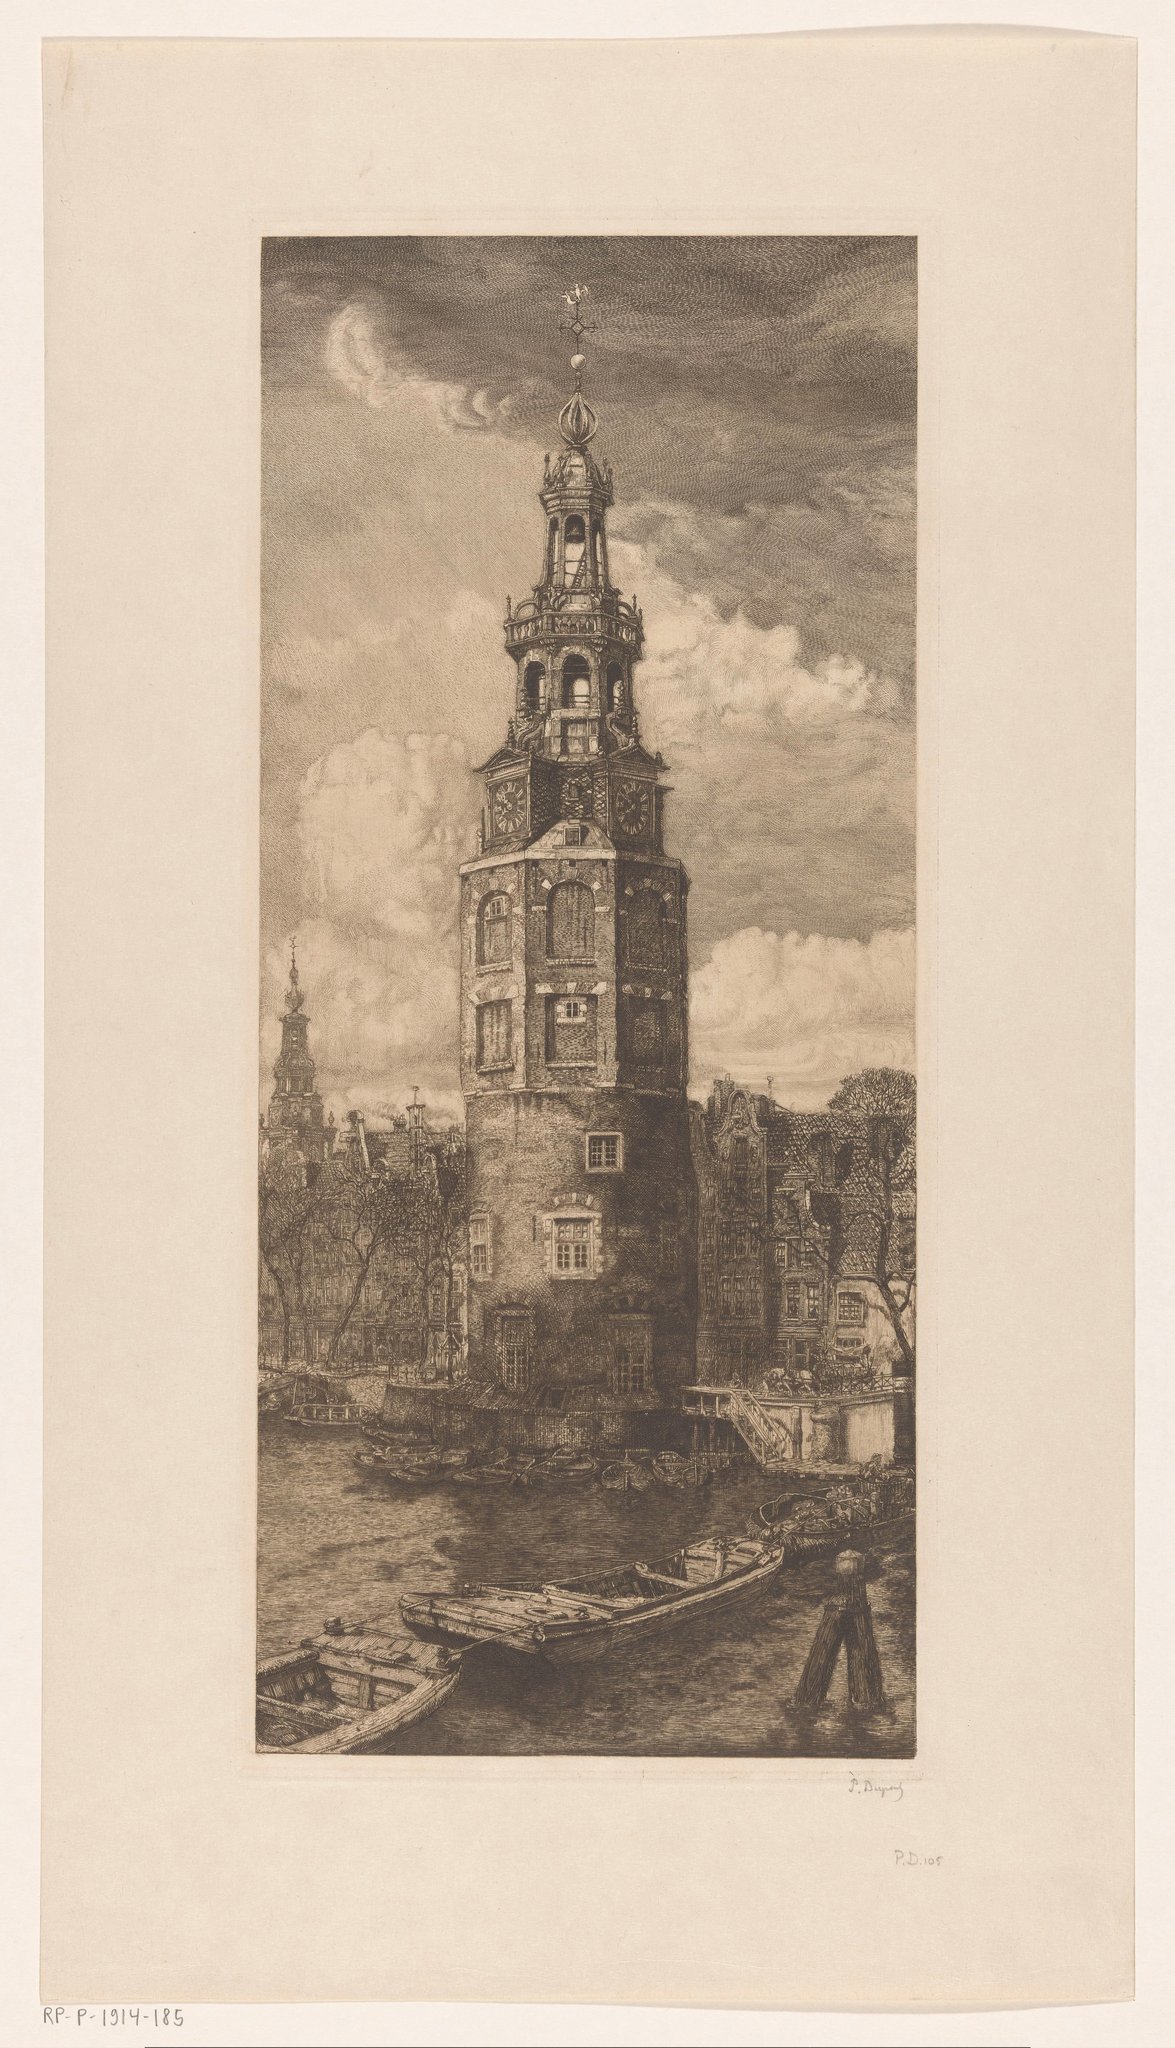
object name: print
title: Montelbaanstoren aan de Oudeschans in Amsterdam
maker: pieter dupont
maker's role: draughtsman, print maker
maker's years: 1870-1911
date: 1908-1909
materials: paper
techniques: engraving, etching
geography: amsterdam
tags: tower, clock tower ~ monumental adornment, canals, waters (in city)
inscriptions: collector's mark: Lugt 2233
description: Op de voorgrond schuiten in het water. Links op de achtergrond de toren van de Zuiderkerk.